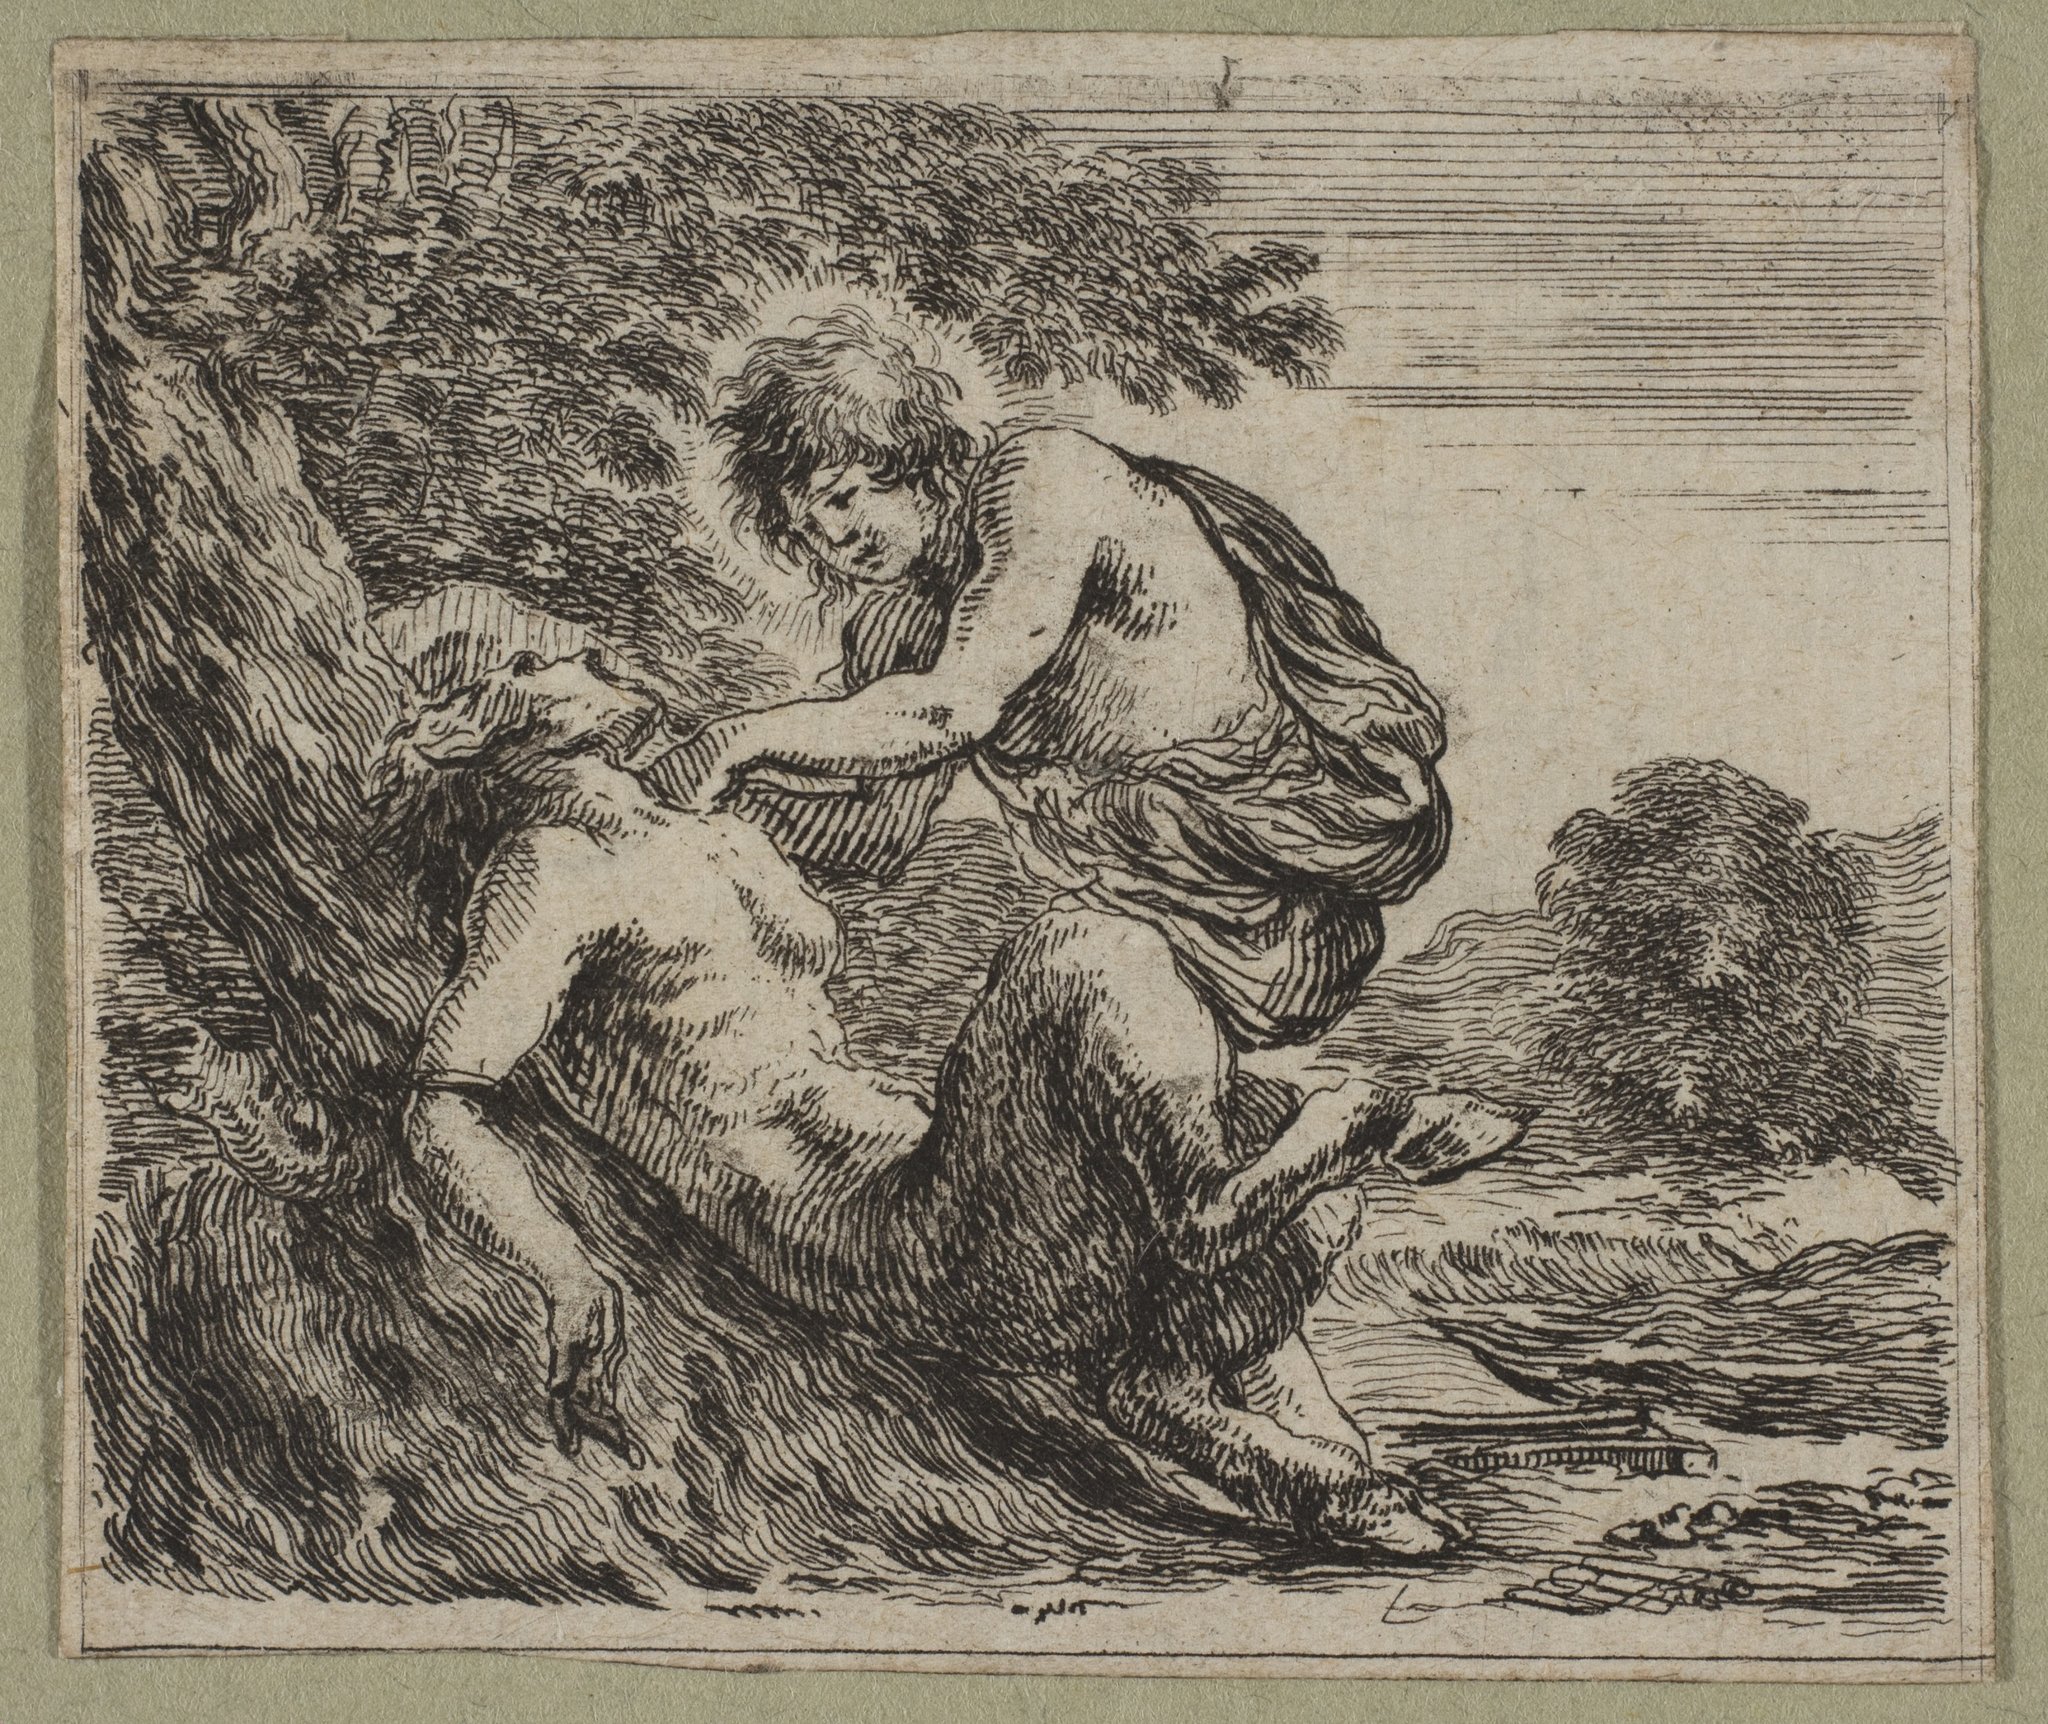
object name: print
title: Apollon et Marsyas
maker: stefano della bella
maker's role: artist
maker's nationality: italian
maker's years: 1610-1664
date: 1644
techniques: etching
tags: apollo,trees